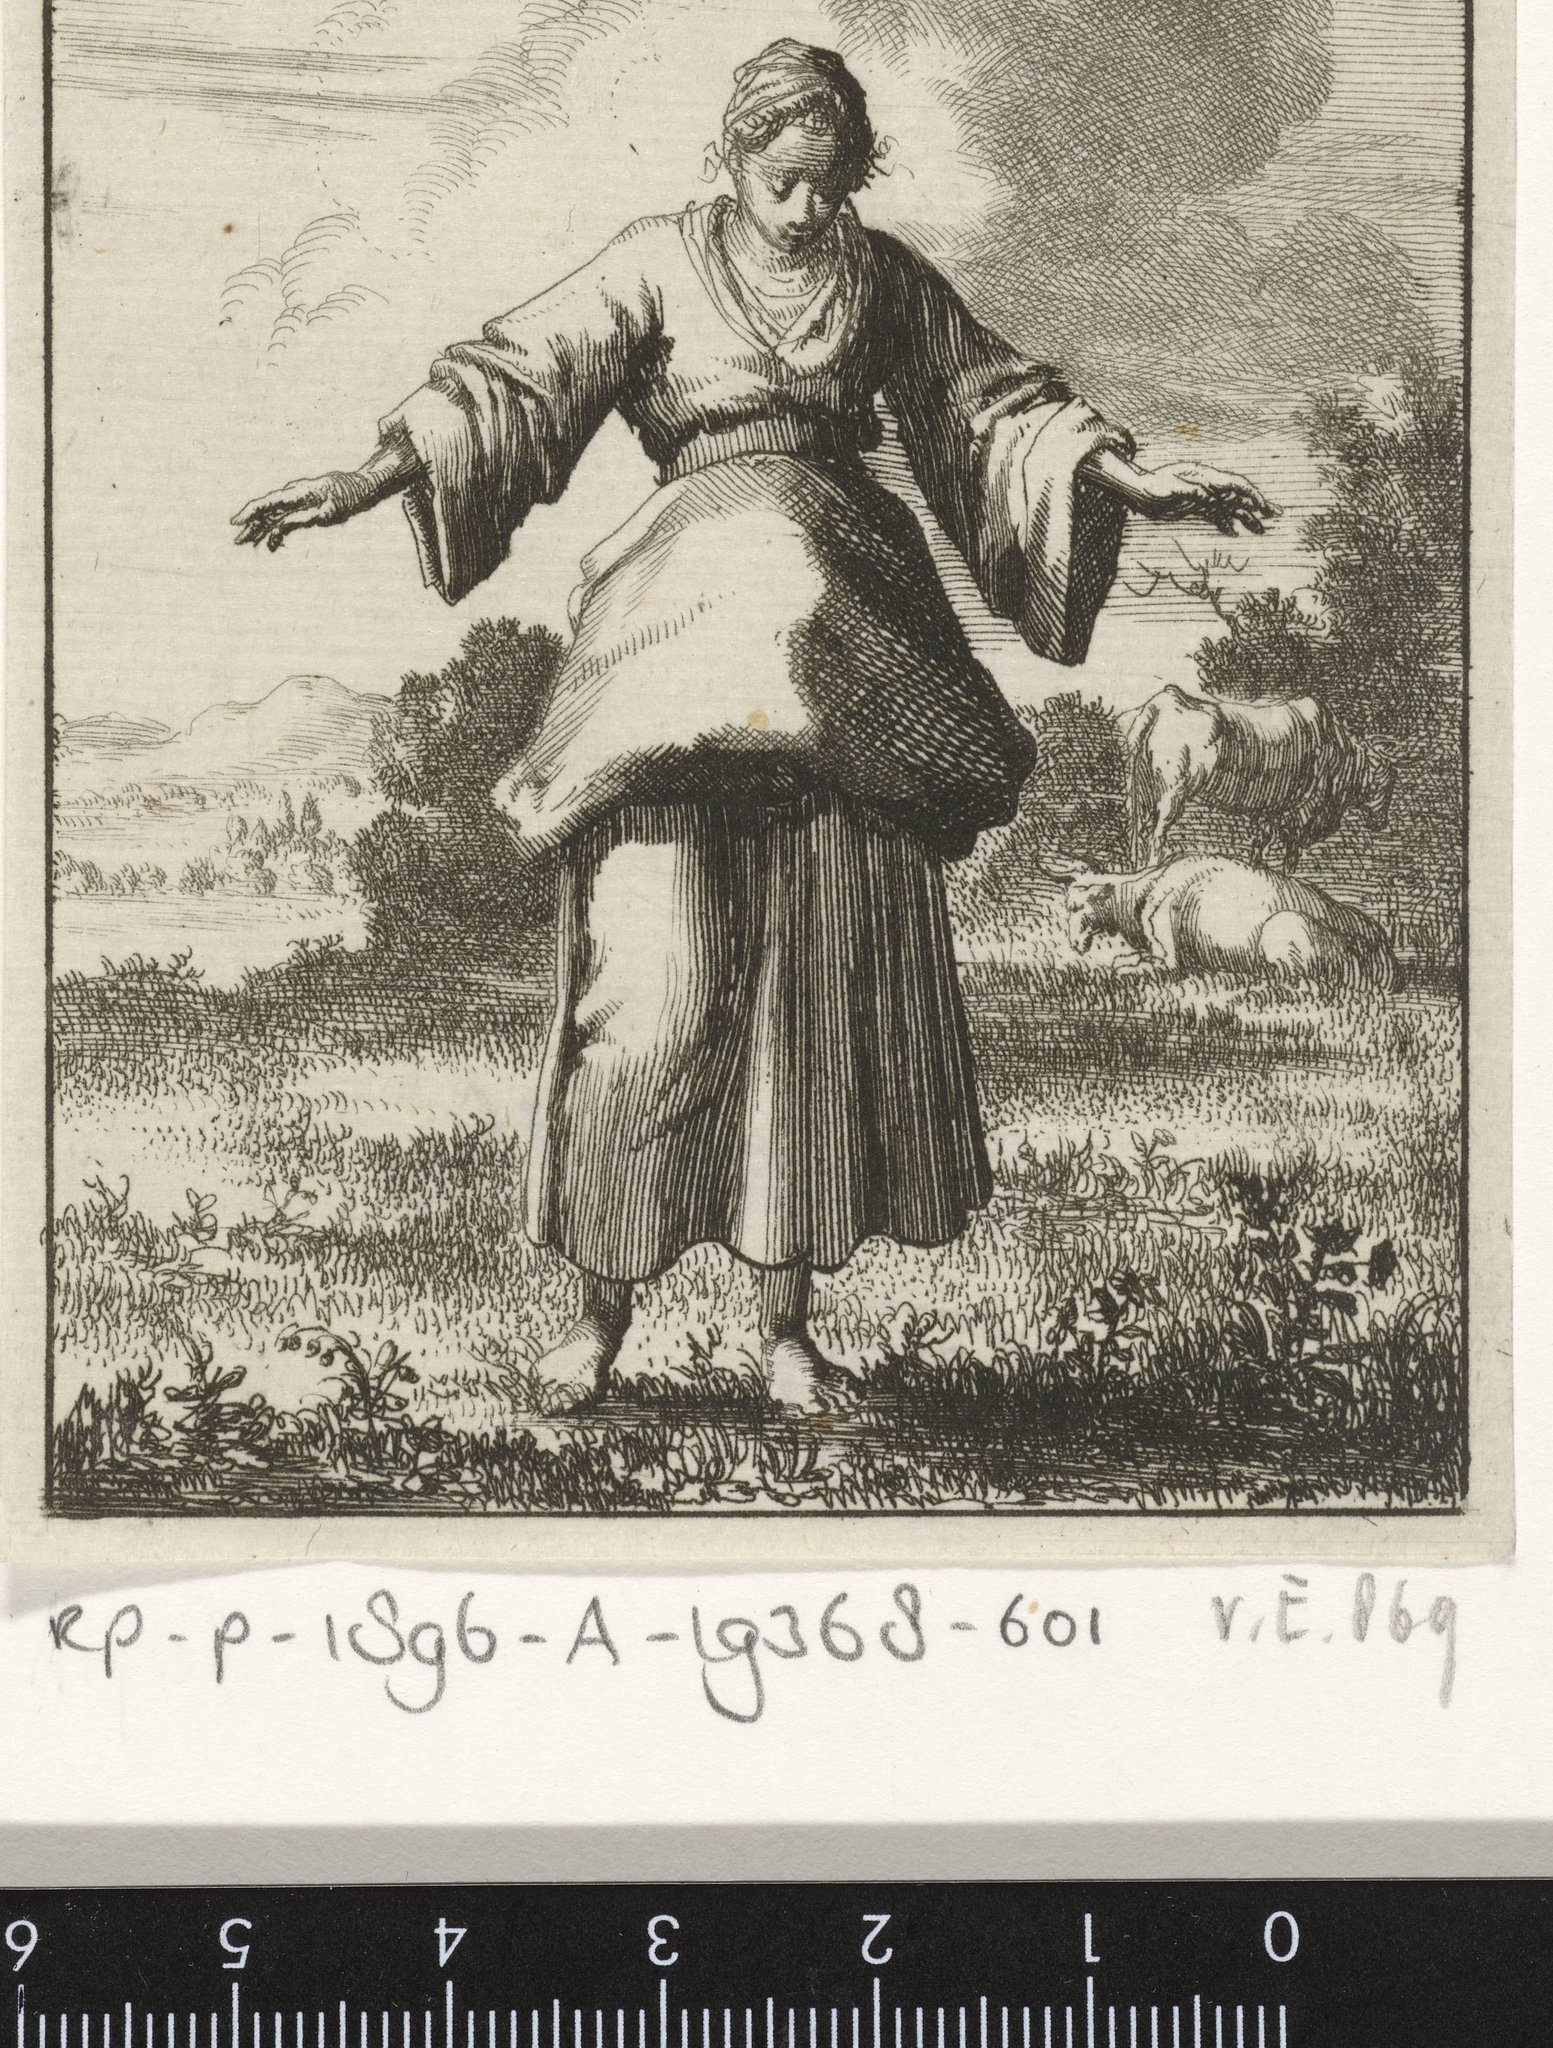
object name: book illustration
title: Vrouw bekijkt verwonderd het gras onder haar voeten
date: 1687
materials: paper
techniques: etching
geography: amsterdam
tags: meadow, pasture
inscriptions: collector's mark: Lugt 2228, number: ‘34’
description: Illustratie uit: Luyken, Jan. Voncken der liefde Jesu, van het godtbegerende zielenvier. Amsterdam: Pieter Arentsz (II), 1687, p. 142.